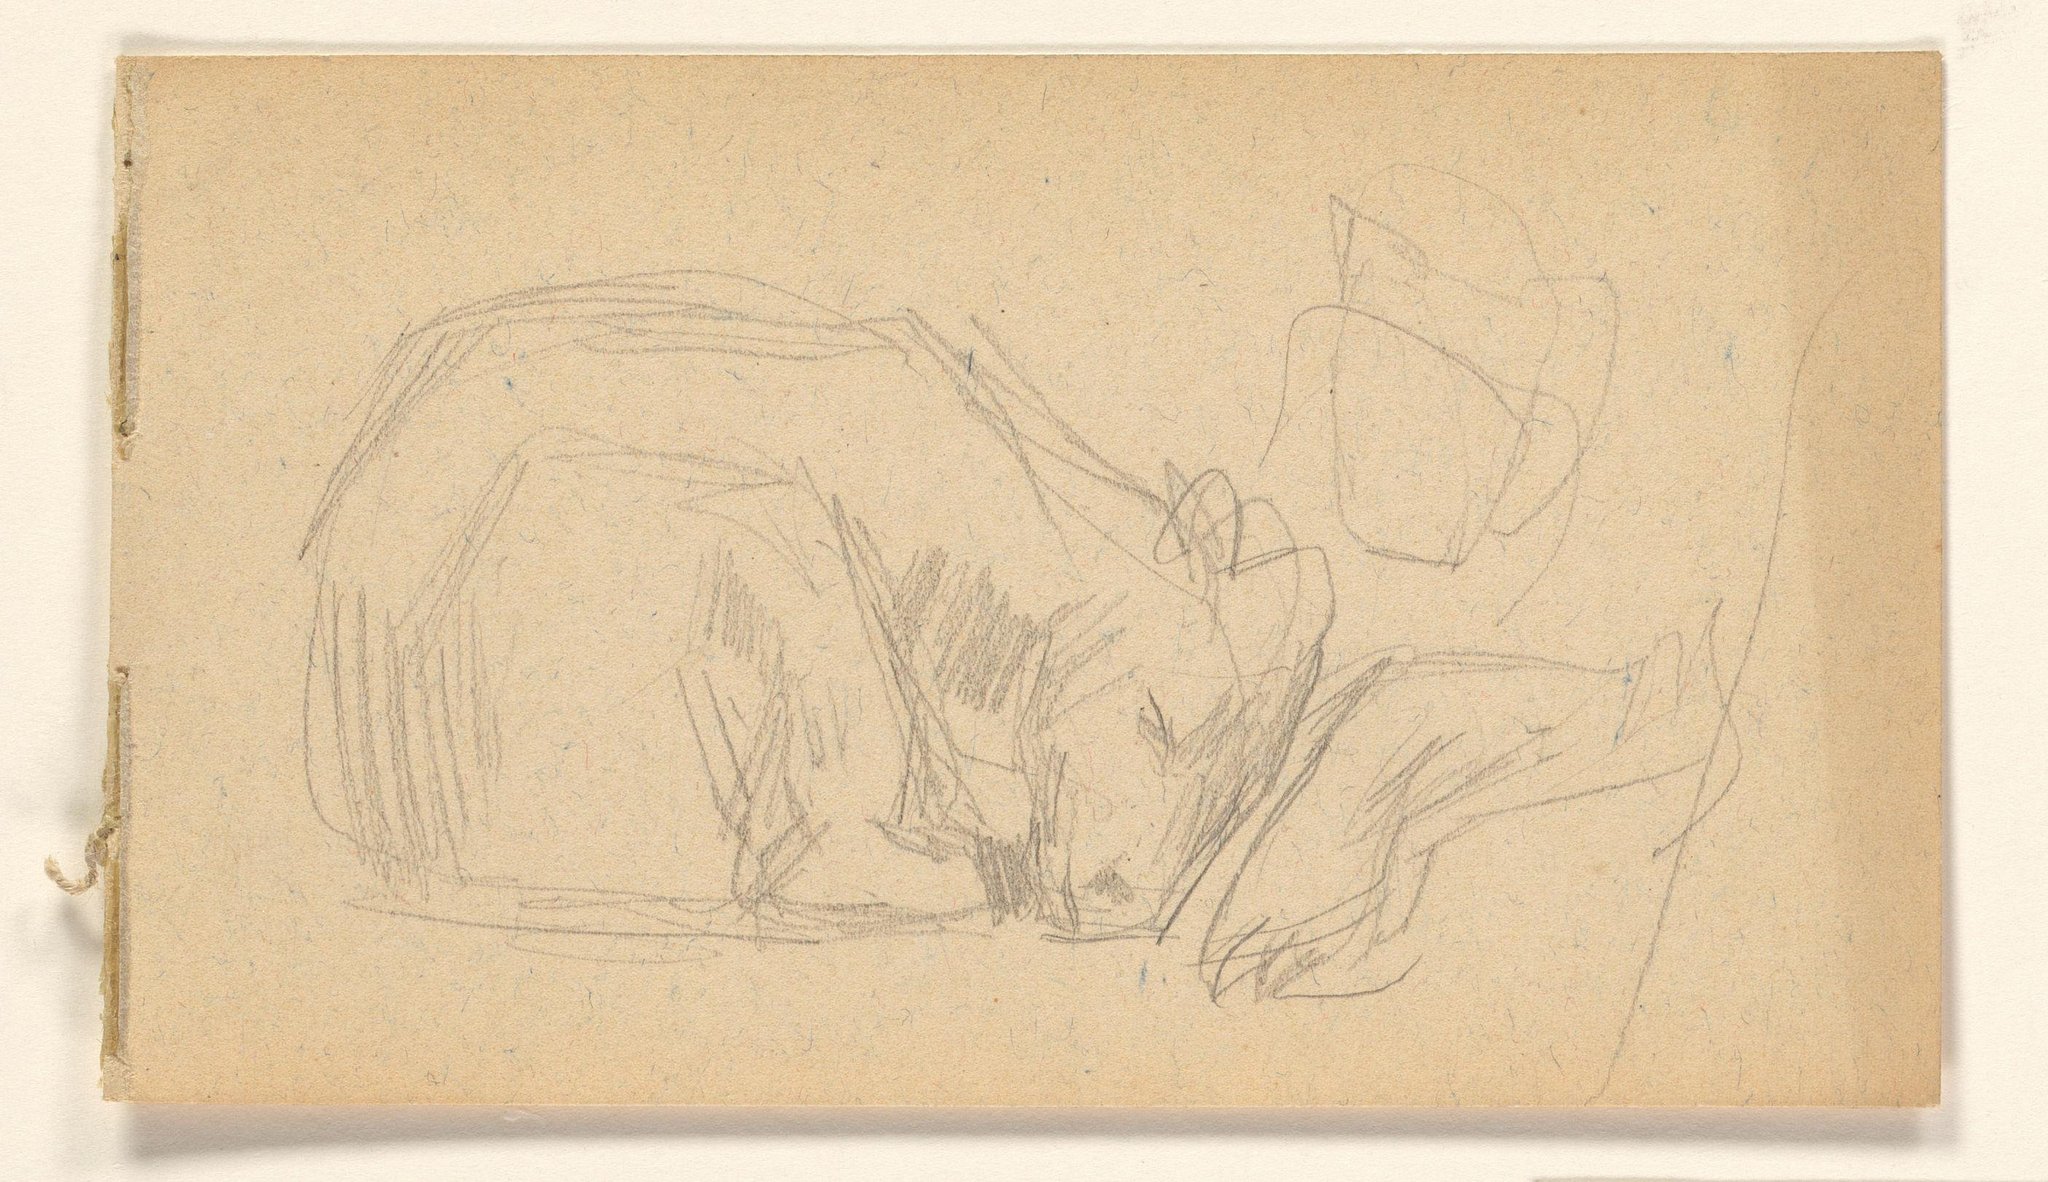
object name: drawing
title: Schetsblad met een liggend dier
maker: august allebé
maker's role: draughtsman, print maker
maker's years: 1838-1927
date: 1848-1927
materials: paper, pencil